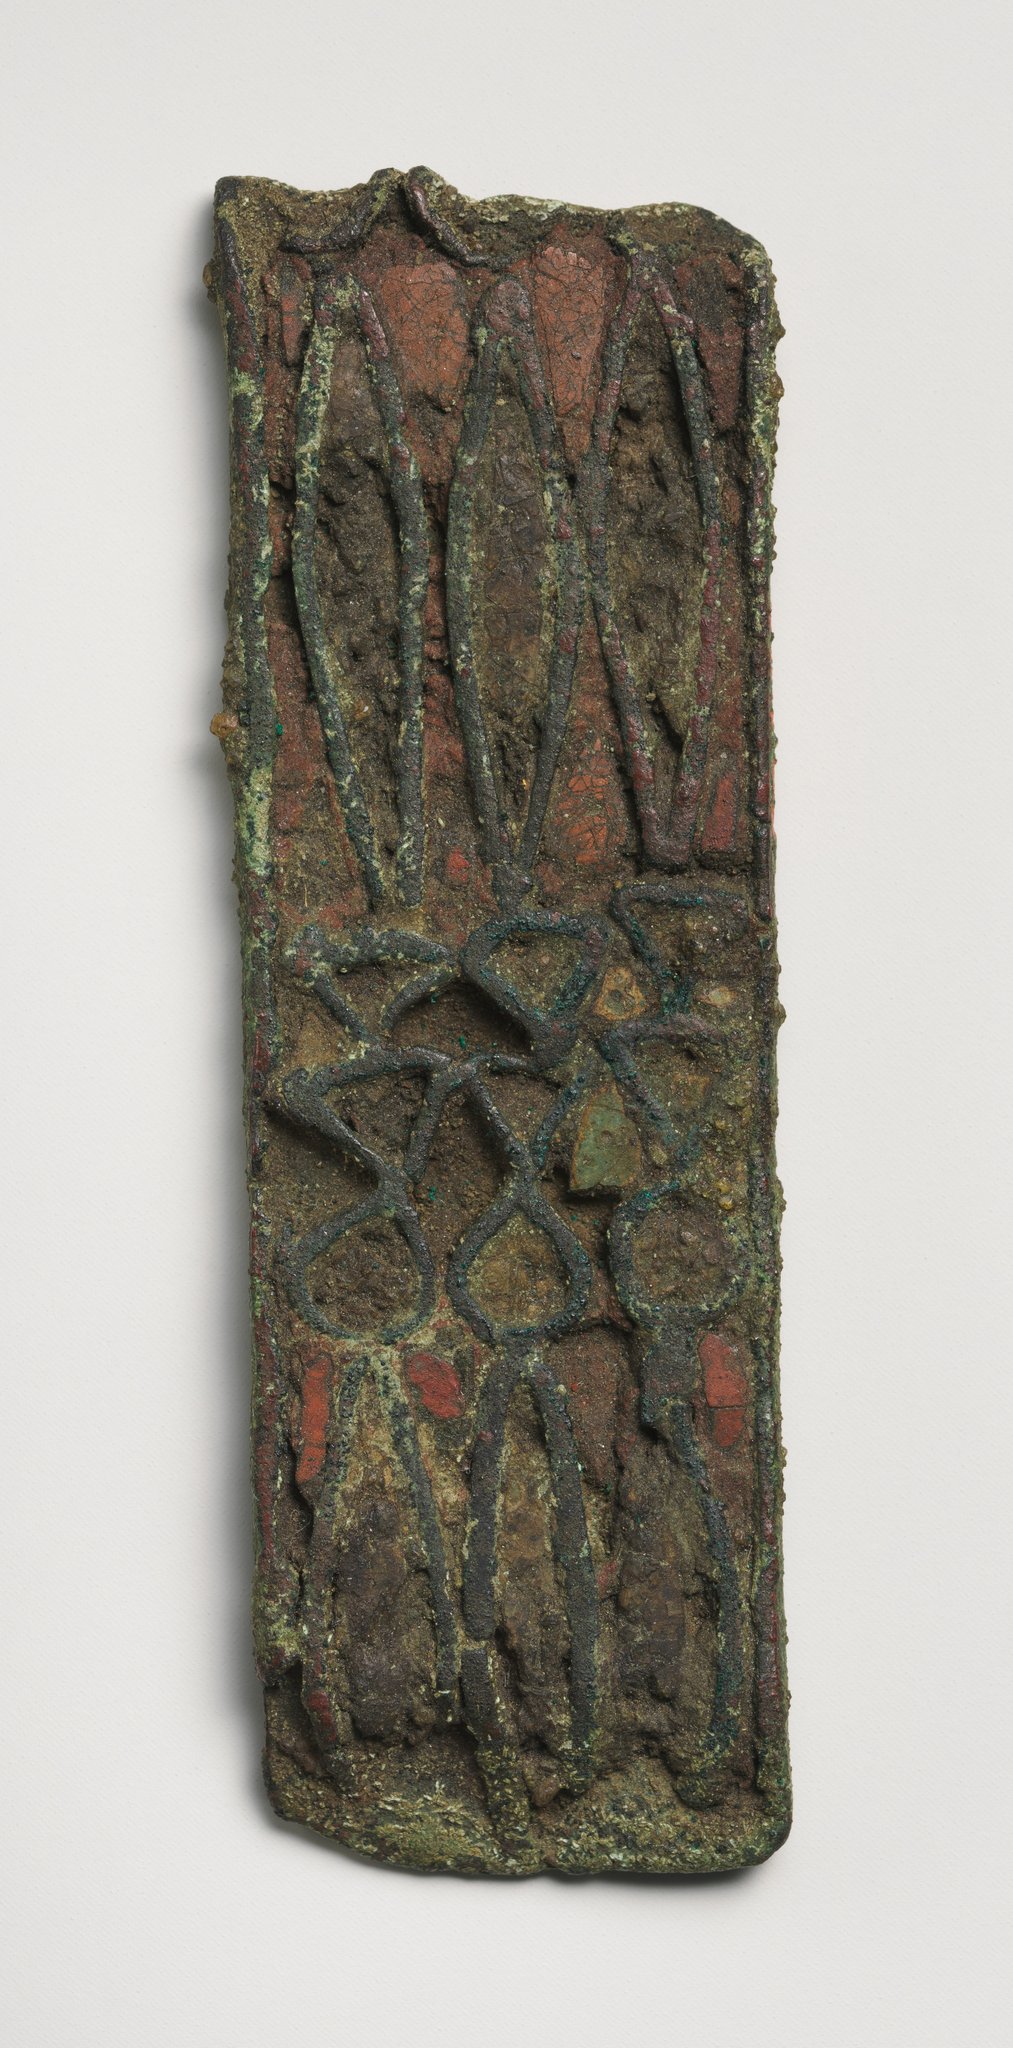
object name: statue, fitting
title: Fitting for the flail of a large statue (?)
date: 332-330 BCE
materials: alloy, bronze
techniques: inlay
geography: egypt